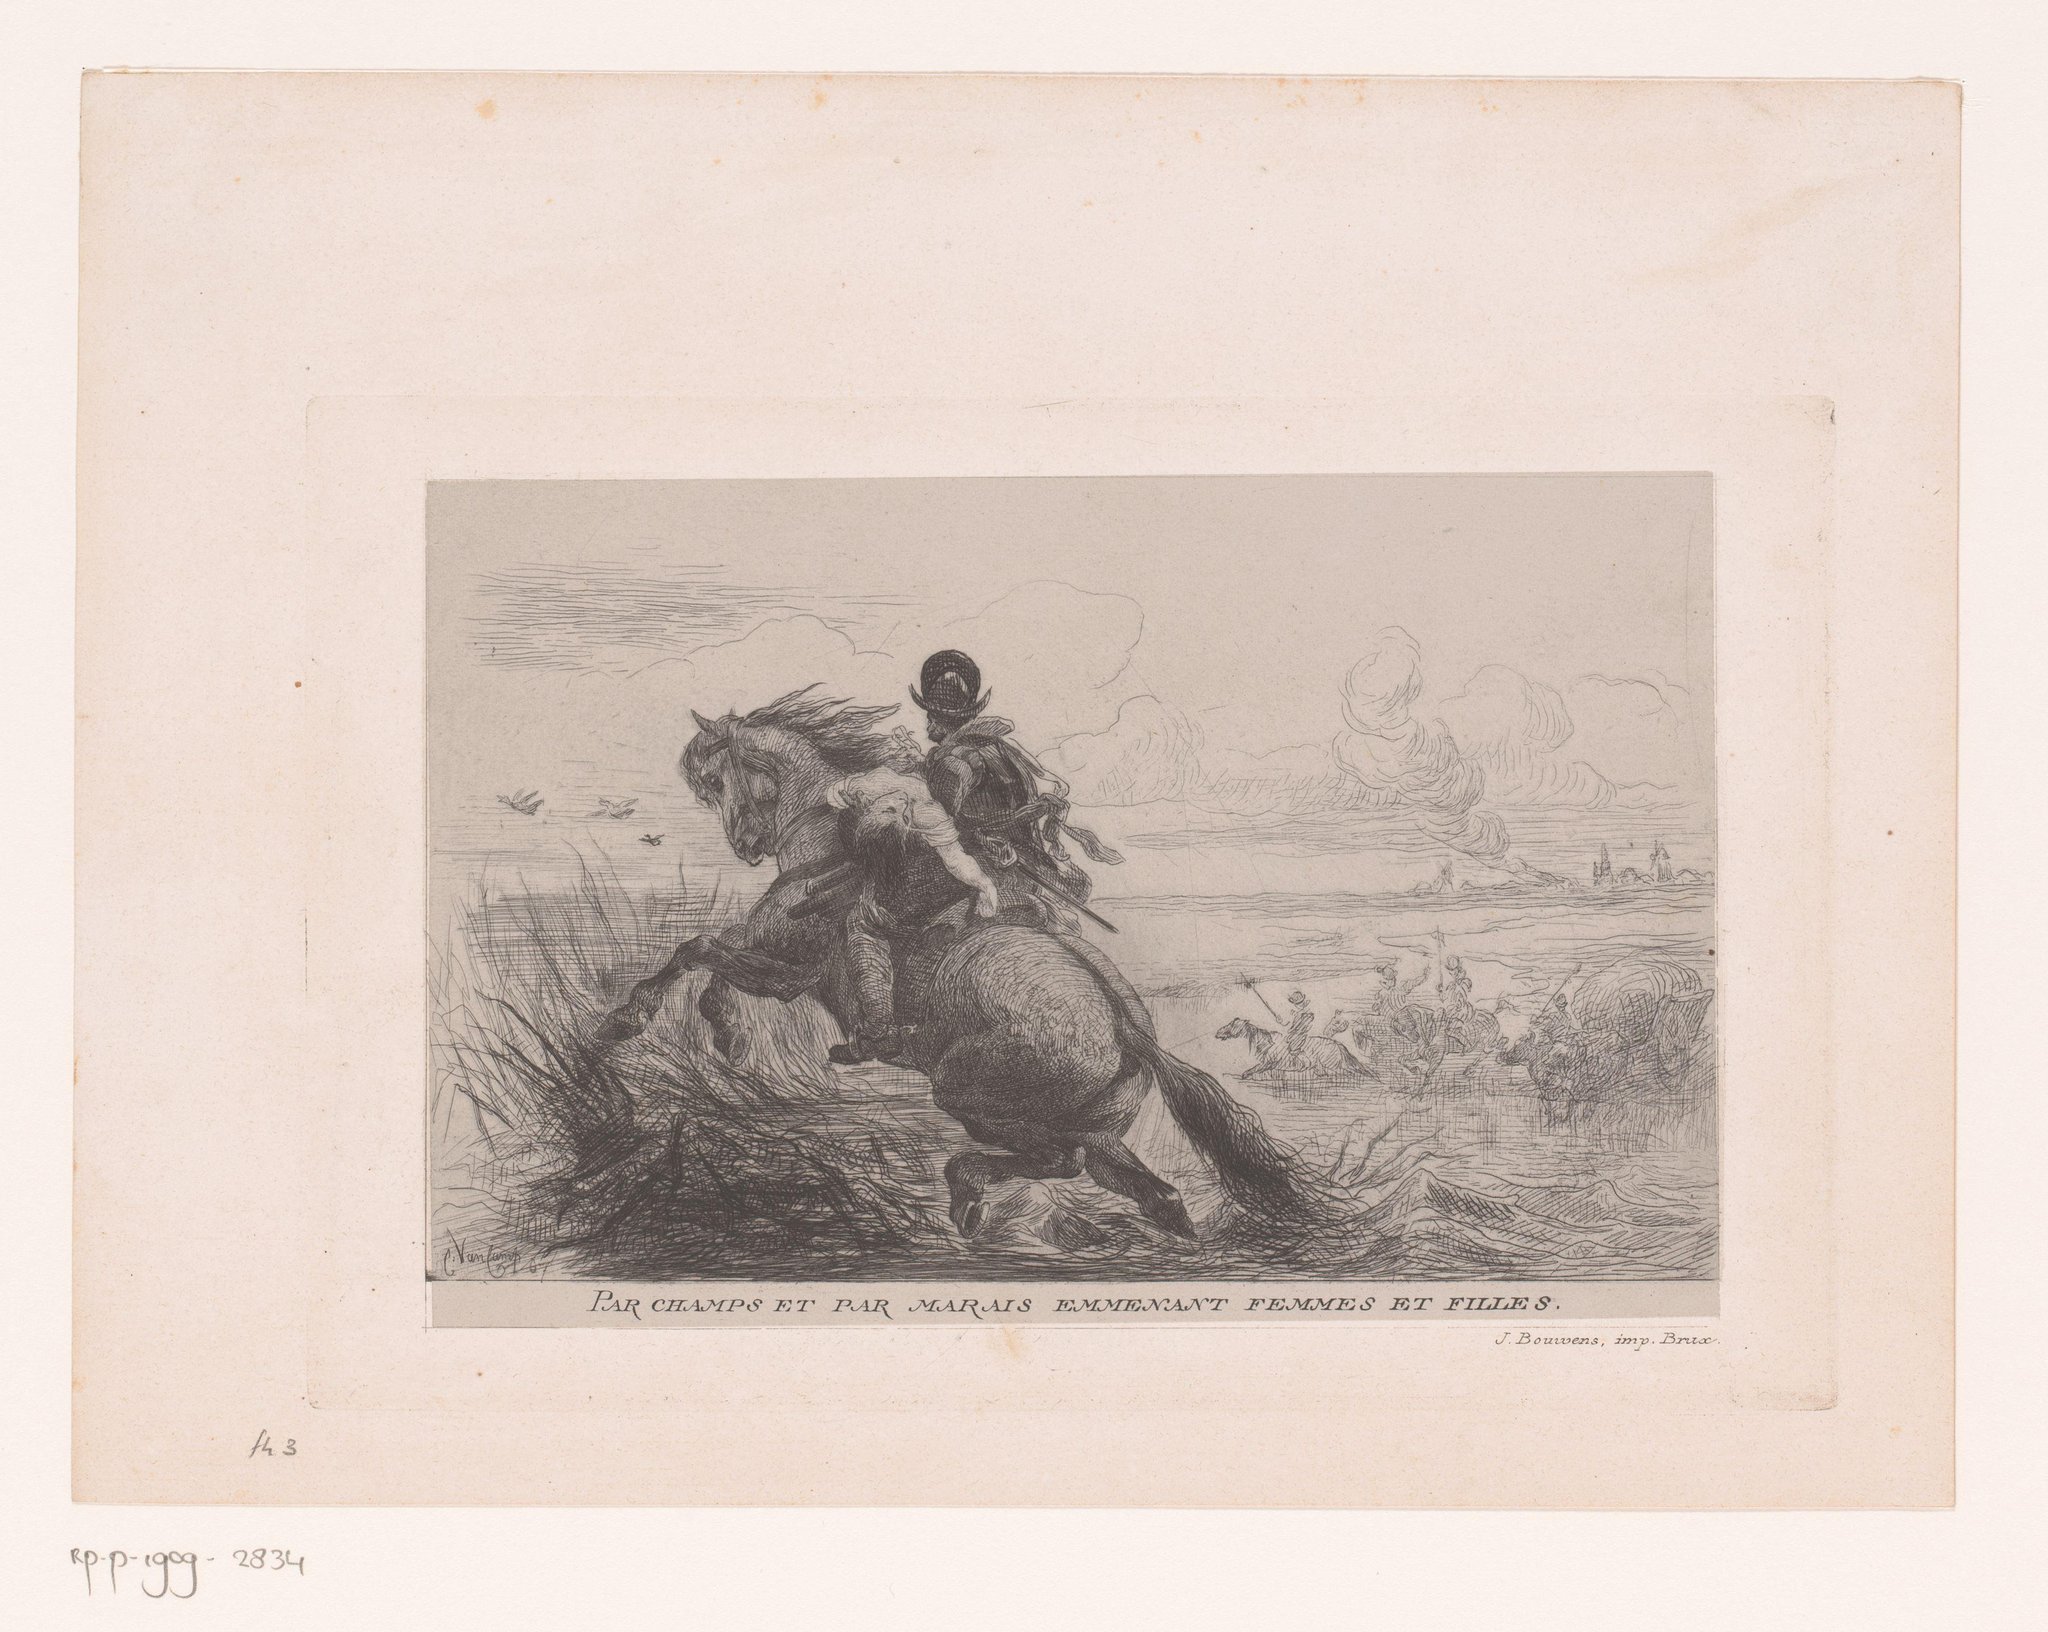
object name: book illustration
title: Spaanse cavalerist ontvoert een vrouw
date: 1867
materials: paper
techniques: etching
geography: brussels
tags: private soldier (+ cavalry, horsemen), man abducting woman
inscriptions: collector's mark: Lugt 2228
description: Prent uit: Coster, Charles de. La légende et les aventures héroiques, joyeuses et glorieuses d'Ulenspiegel et de Lamme Goedzak (...). Brussel: s.n., 1867, p. 446.